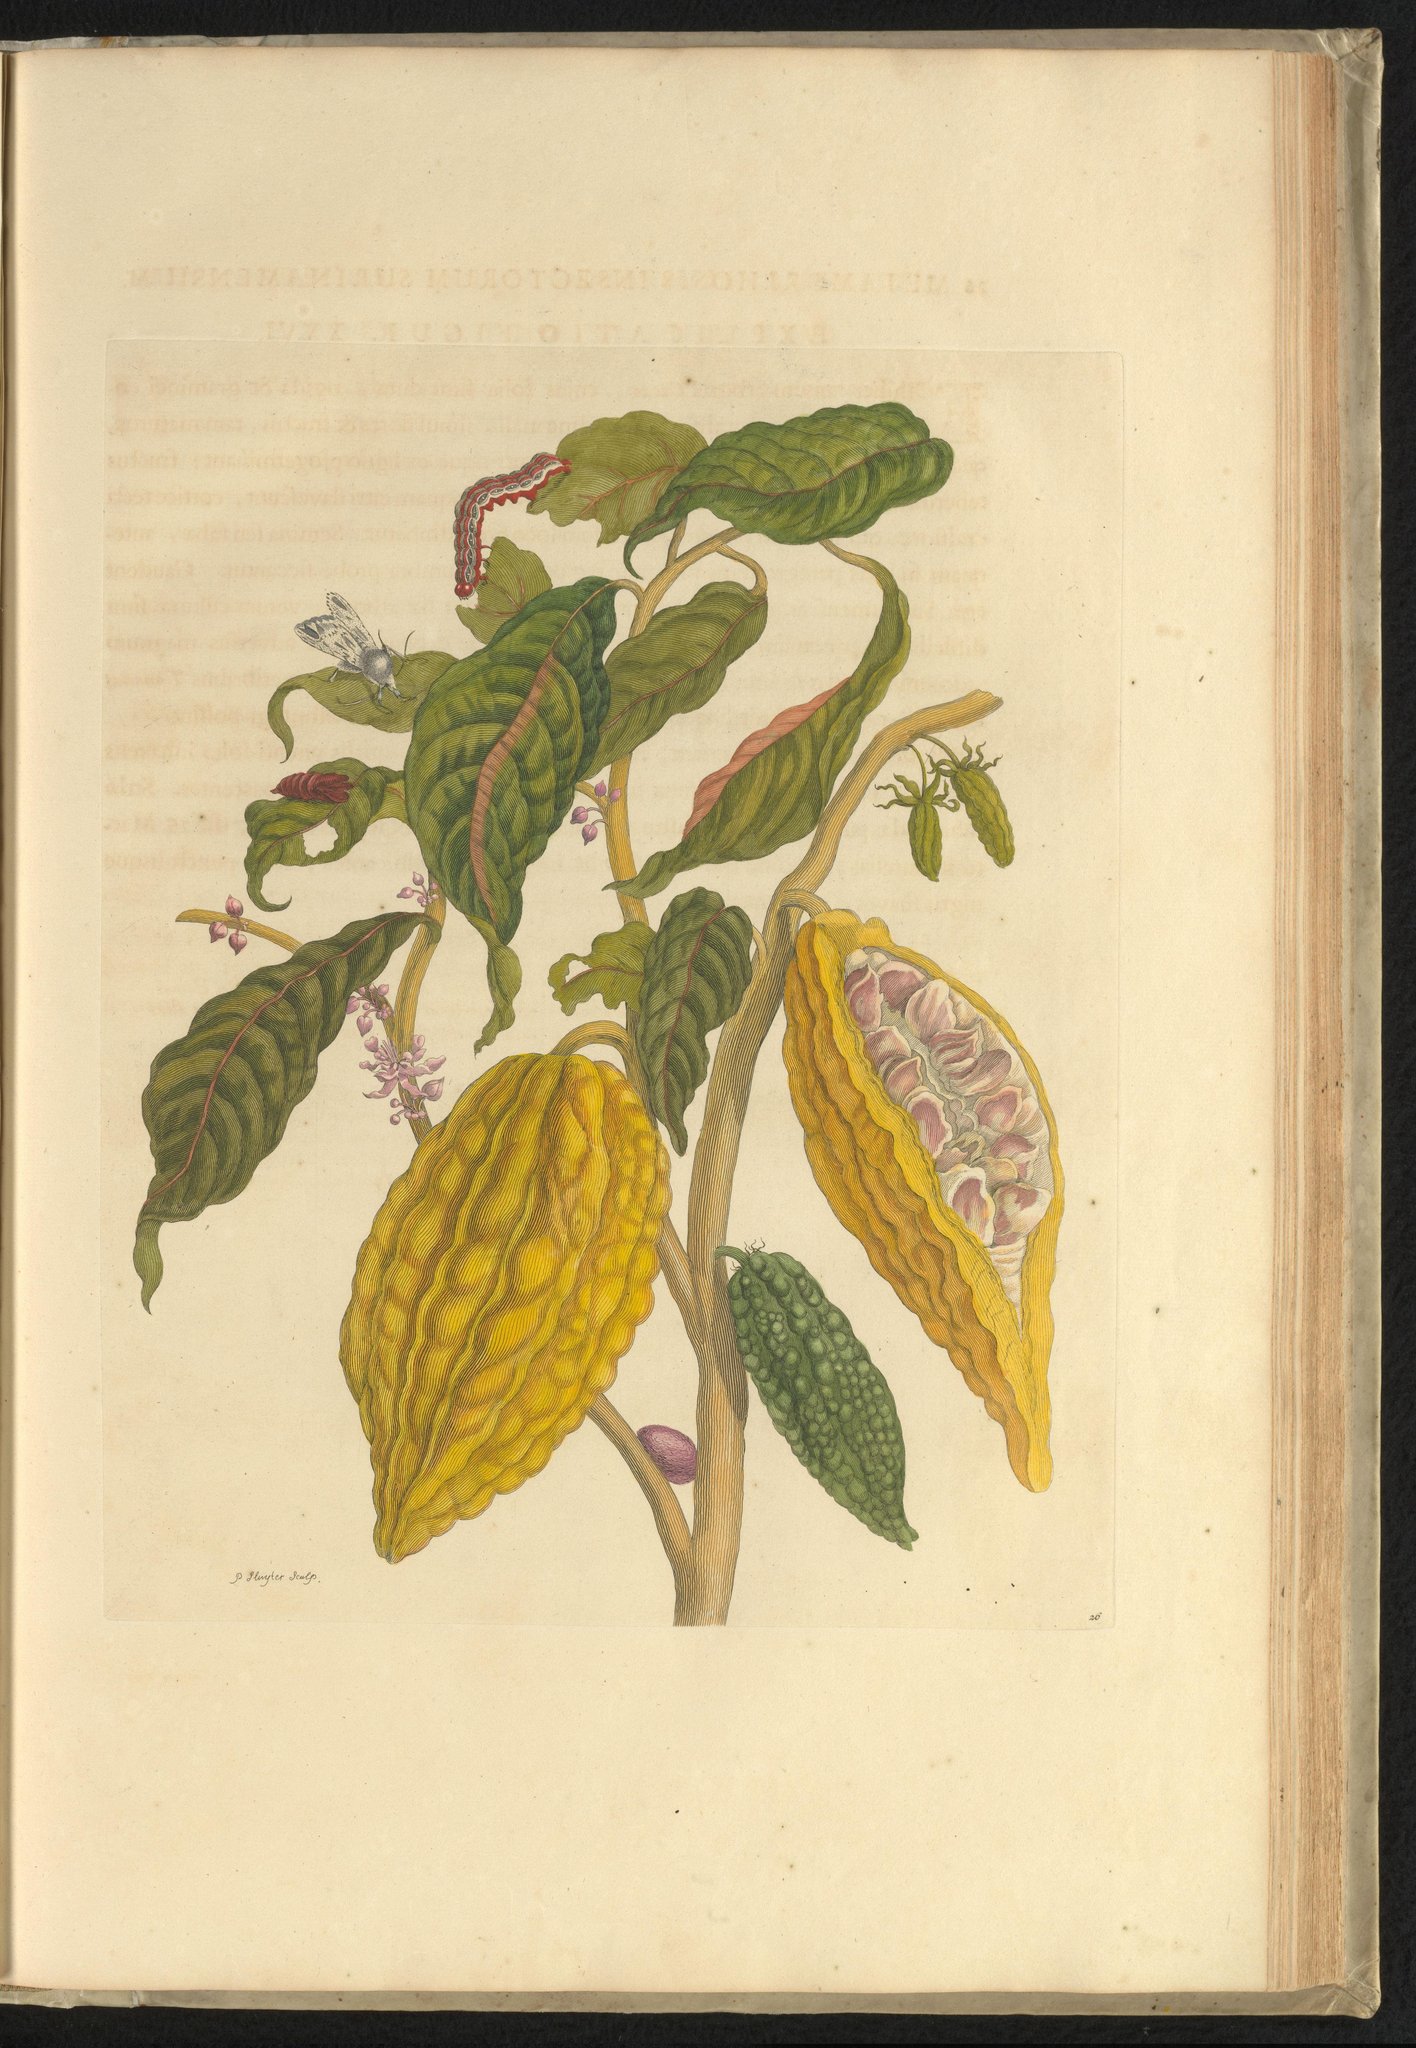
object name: page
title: Cacaoboom (Theobroma cacao) met nachtvlinder, rups en pop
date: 1705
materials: paper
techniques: etching, hand coloring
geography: amsterdam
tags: insects: pupa, fruits: cacao, insects: moth, insects: caterpillar, suriname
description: Rechtsonder genummerd: 26. Prent maakt deel uit van een boek.